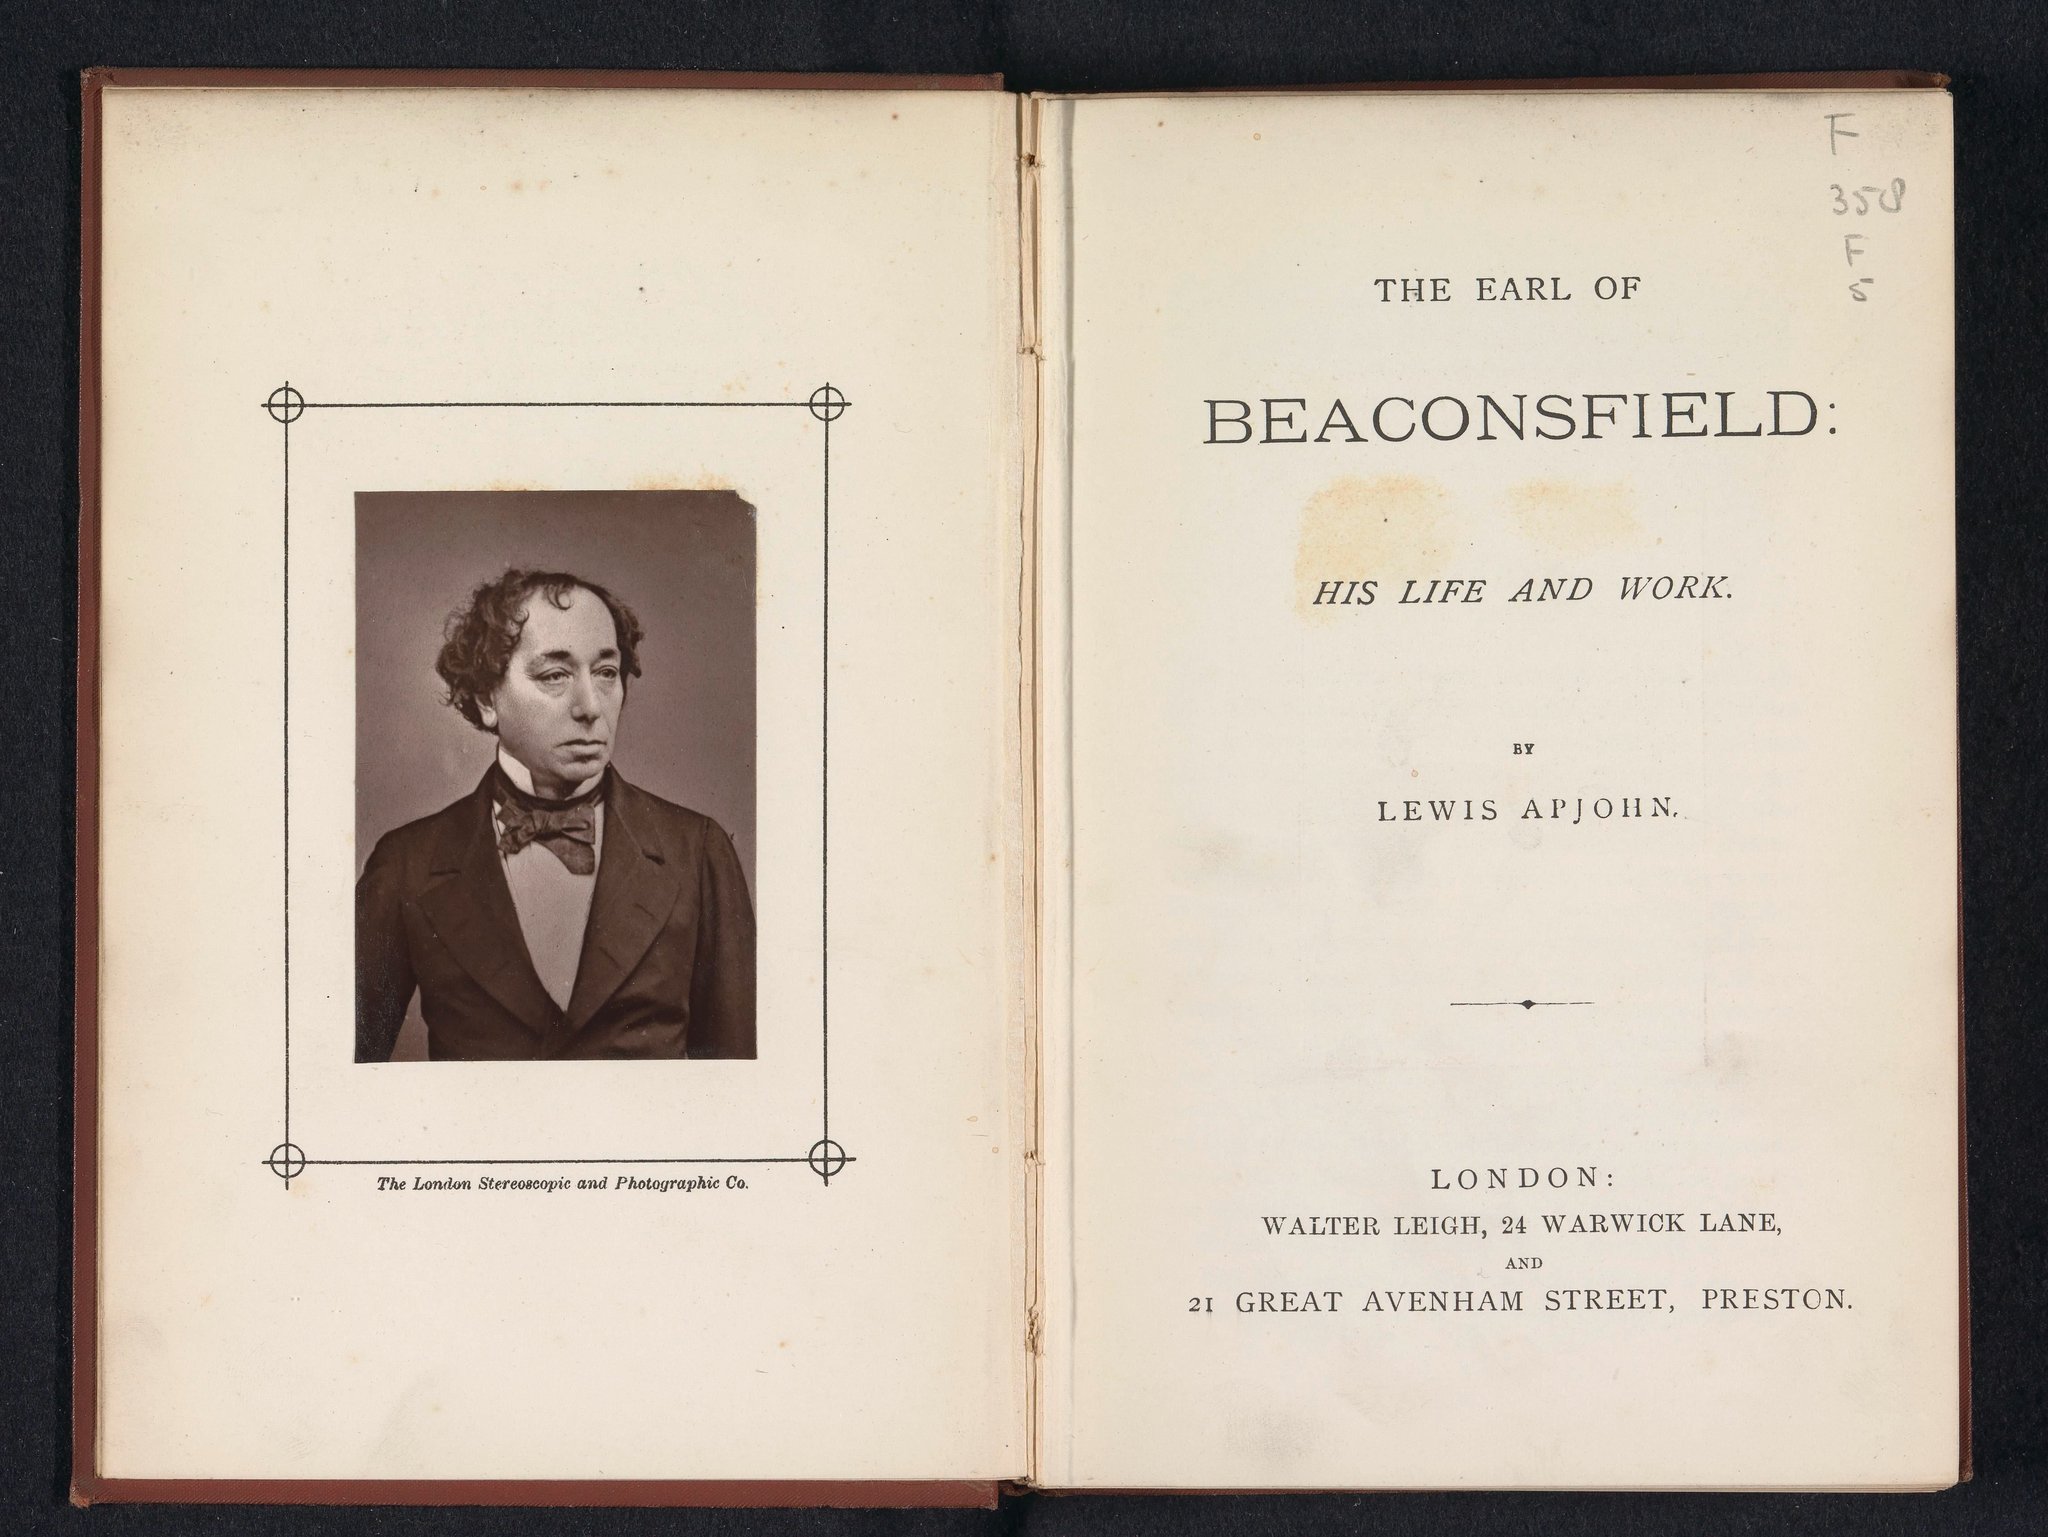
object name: book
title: The earl of Beaconsfield his life and work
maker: lewis apjohn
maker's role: schrijver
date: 1884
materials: cardboard, linen, paper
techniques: woodburytype